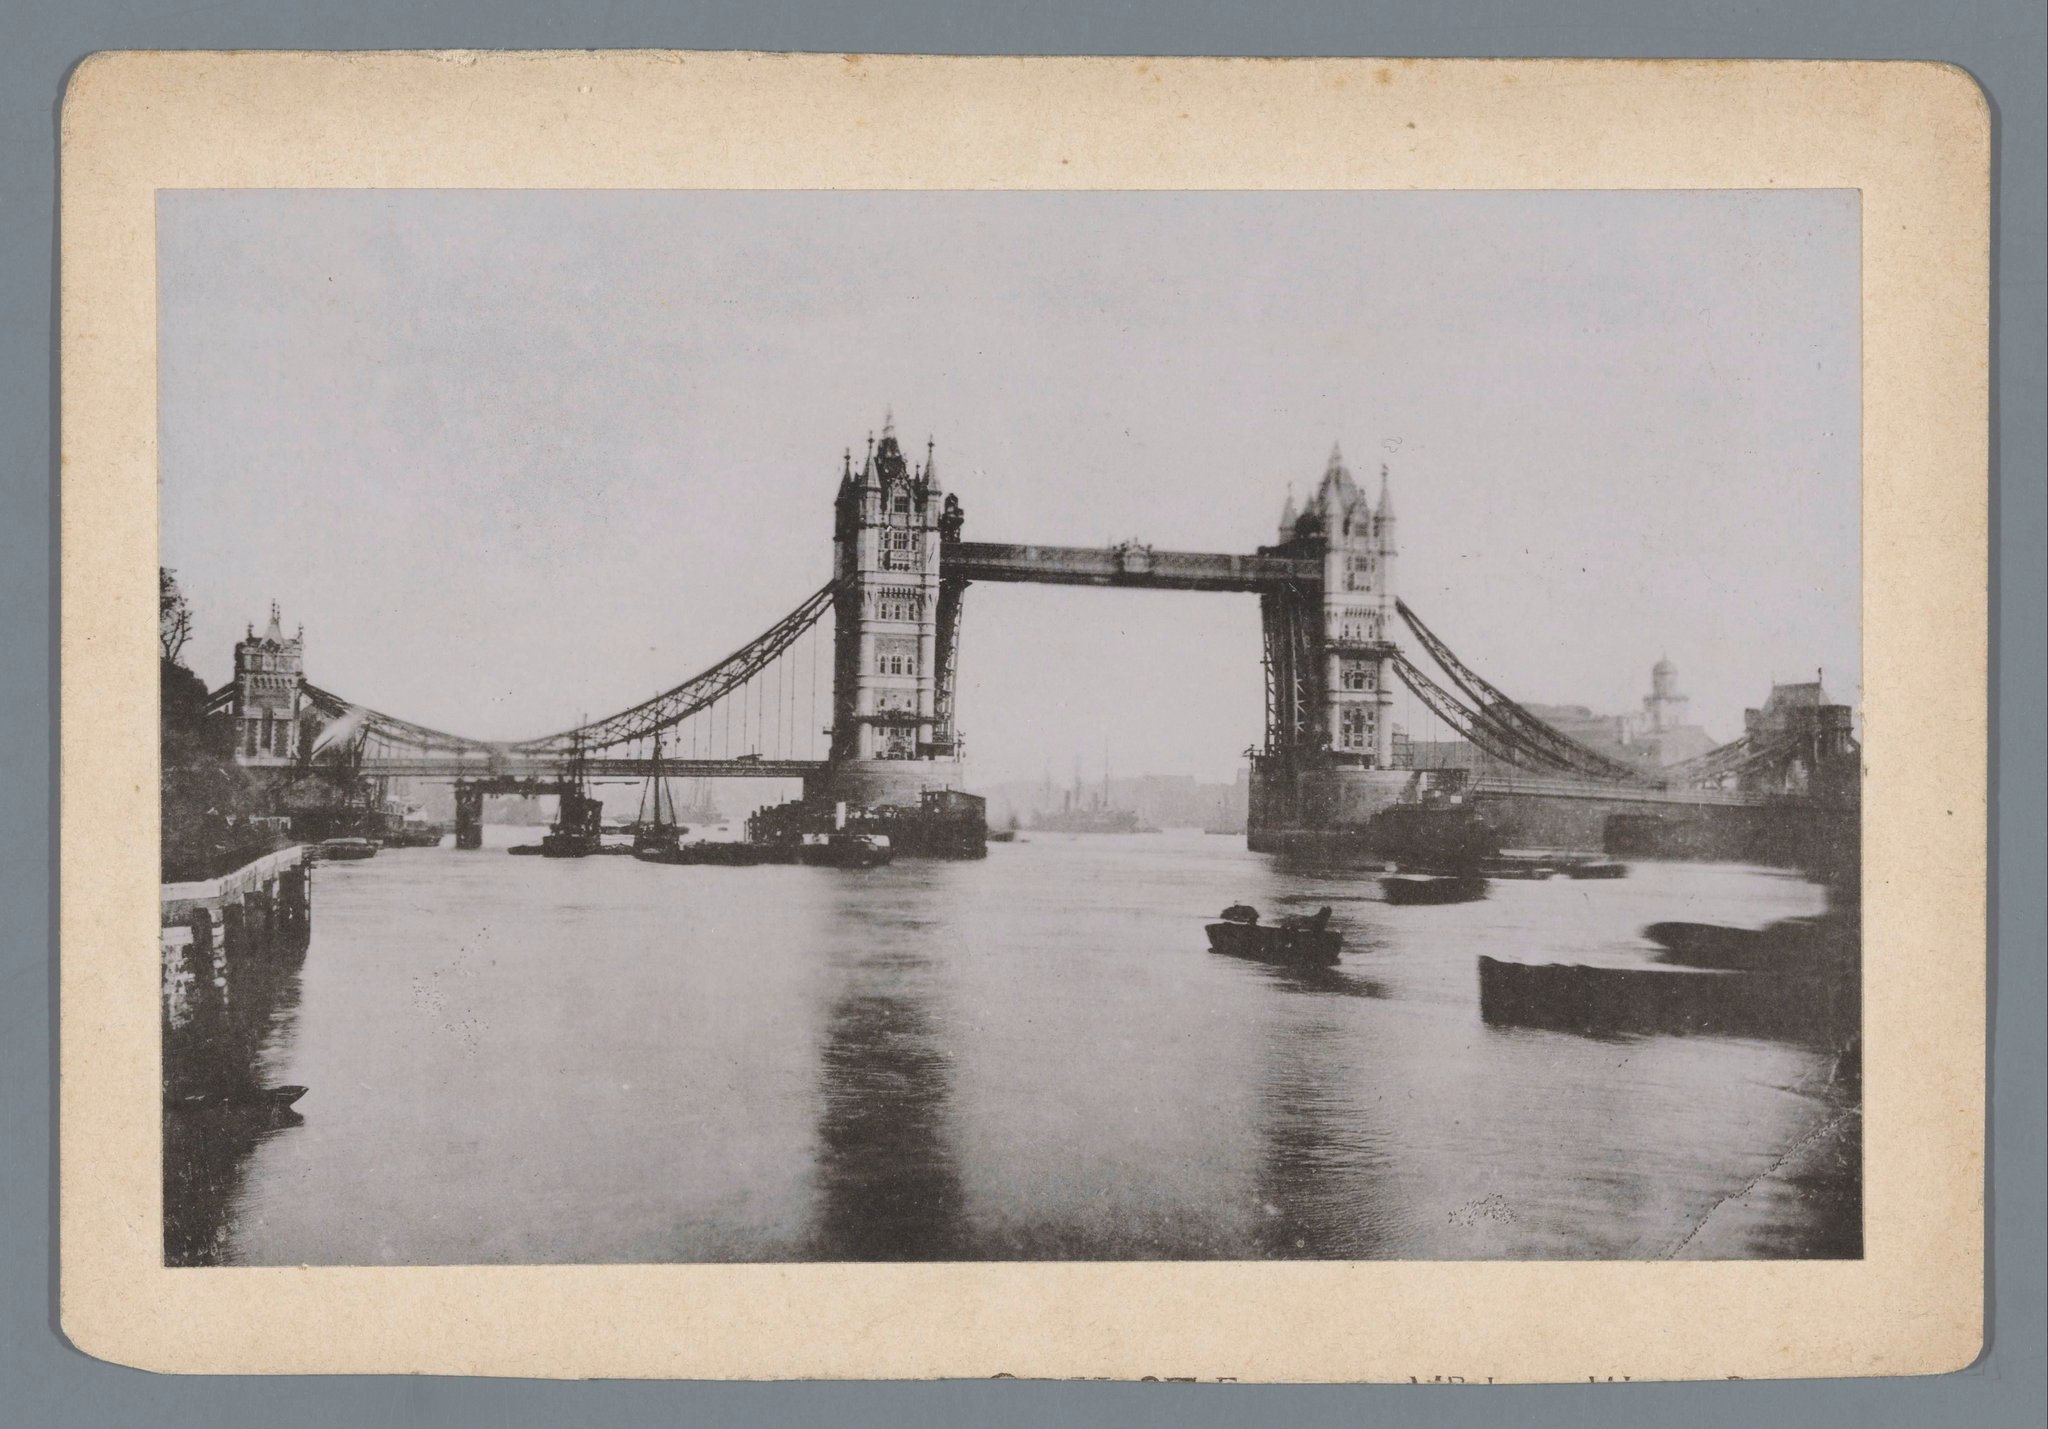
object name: cabinet photograph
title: Gezicht op Tower Bridge in Londen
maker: Anonymous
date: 1894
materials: cardboard, paper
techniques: photograph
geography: tower bridge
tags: bridge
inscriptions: inscription: ‘(...)’, inscription: ‘In commemoration of the Opening Ceremony of the Tower Bridge/ By their royal highnesses The Prince & Princess of Wales on behalf of Her Majesty The Queen/ June 30th 1894.’